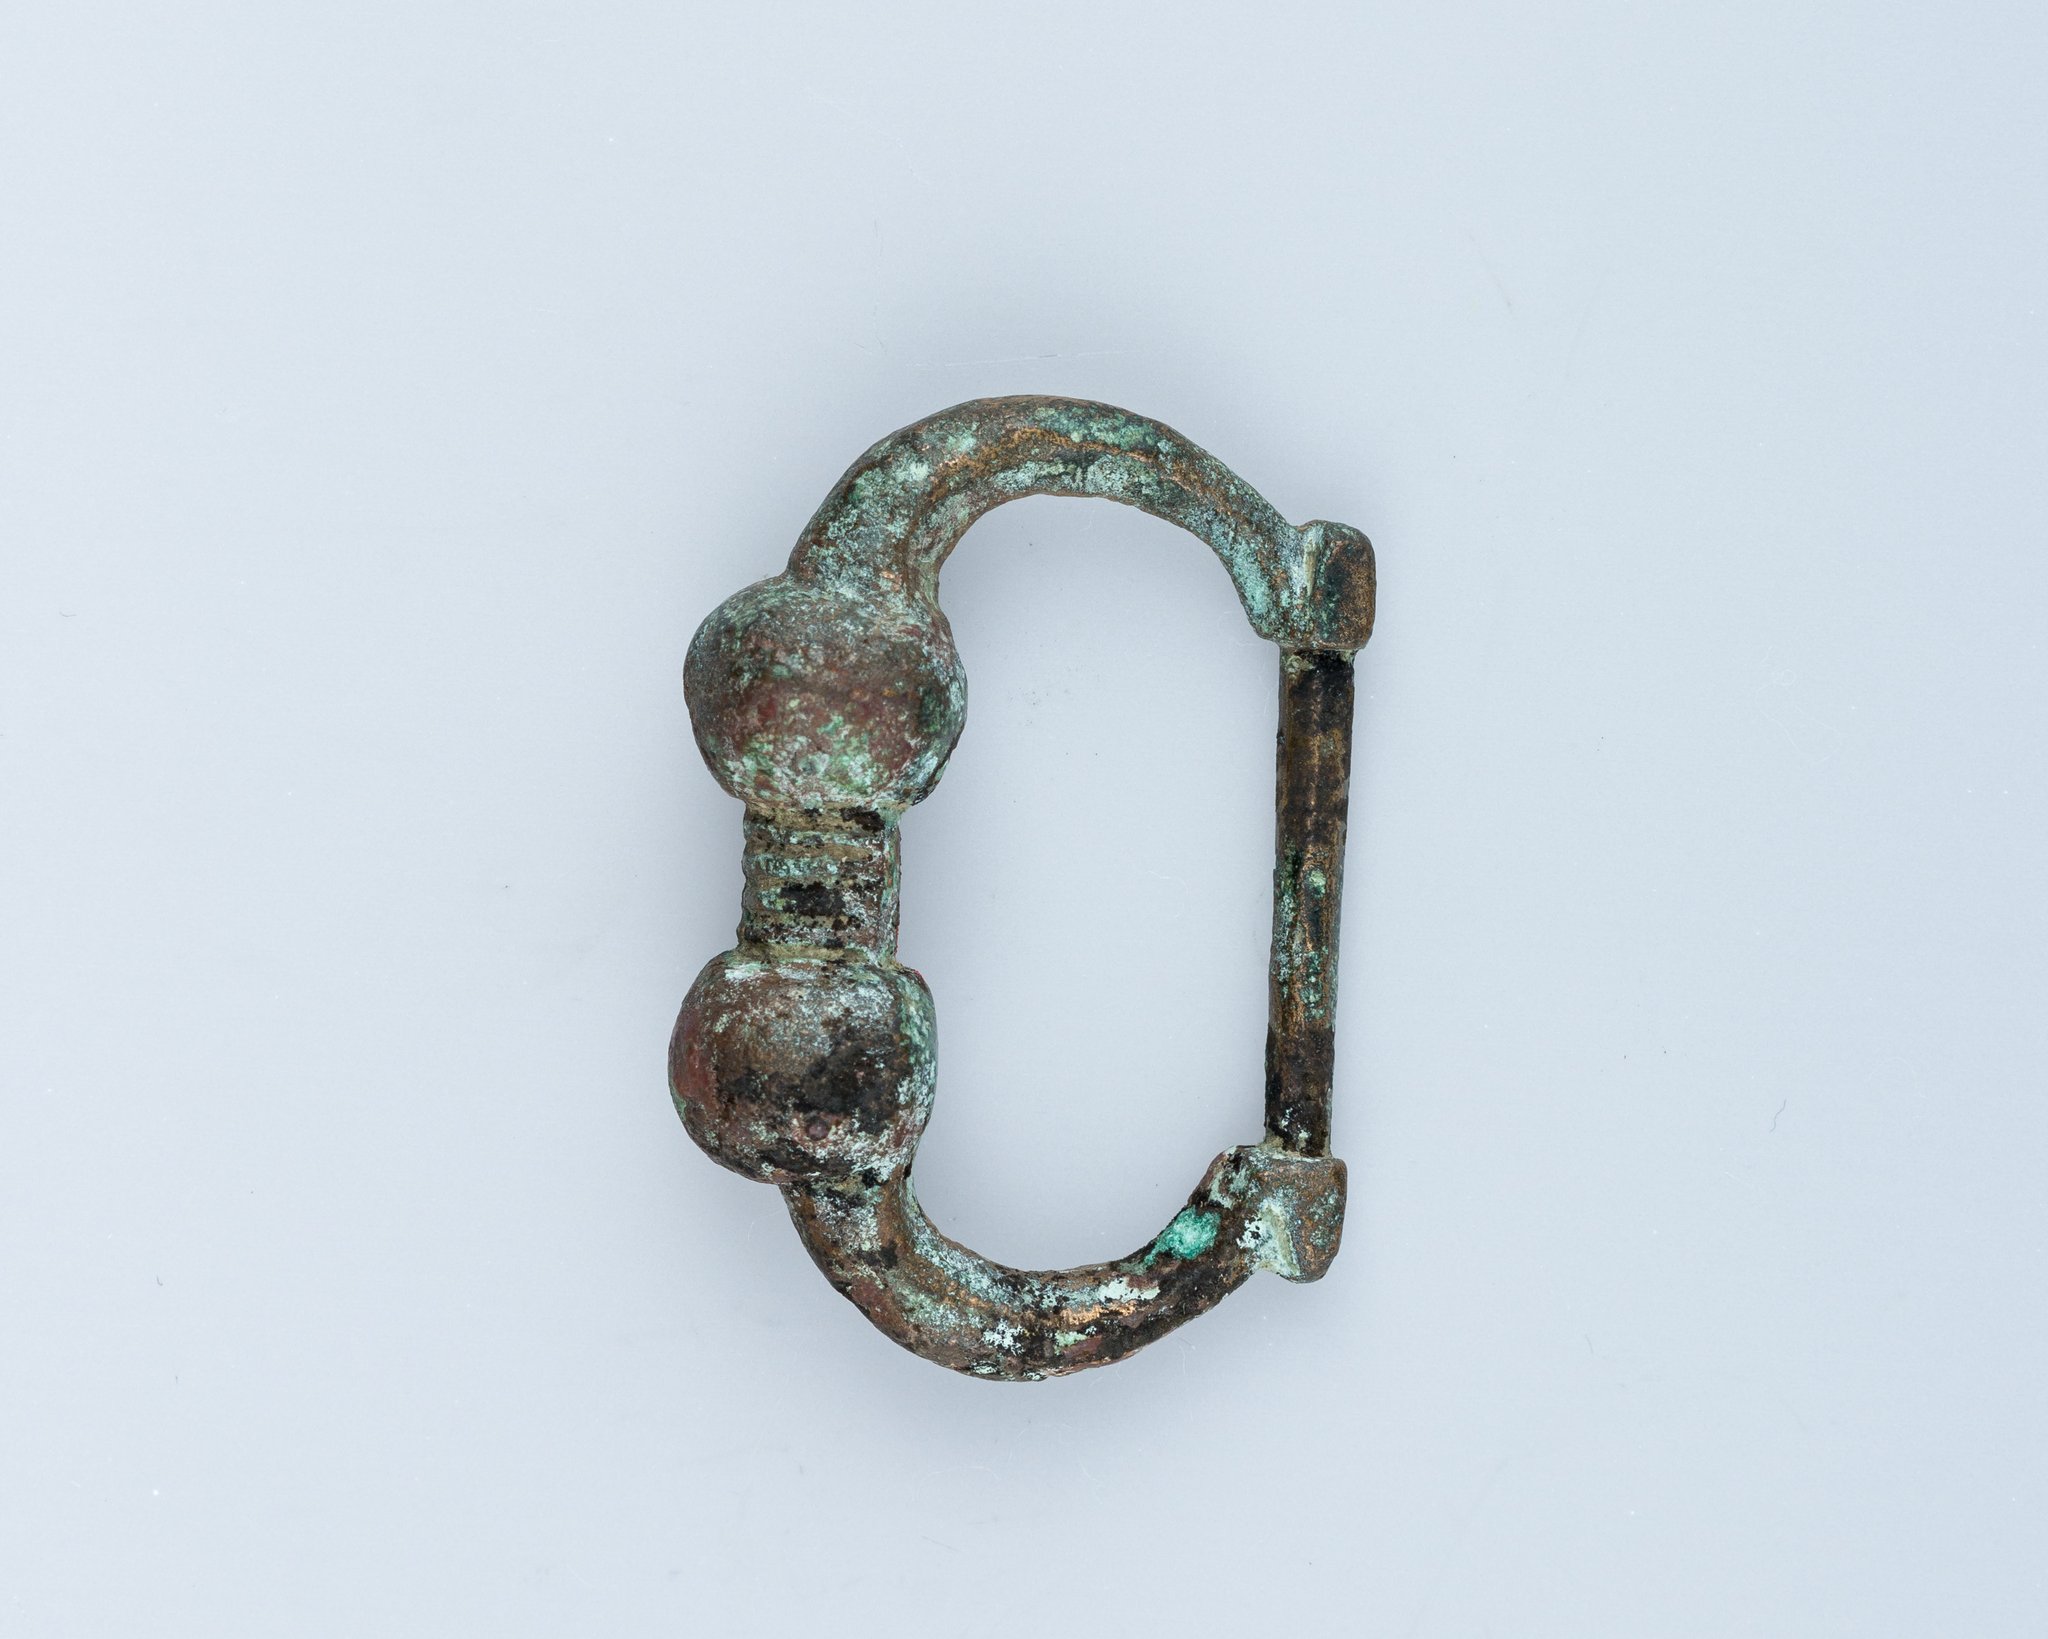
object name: buckle loop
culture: french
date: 1201-1300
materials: bronze, patina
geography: france